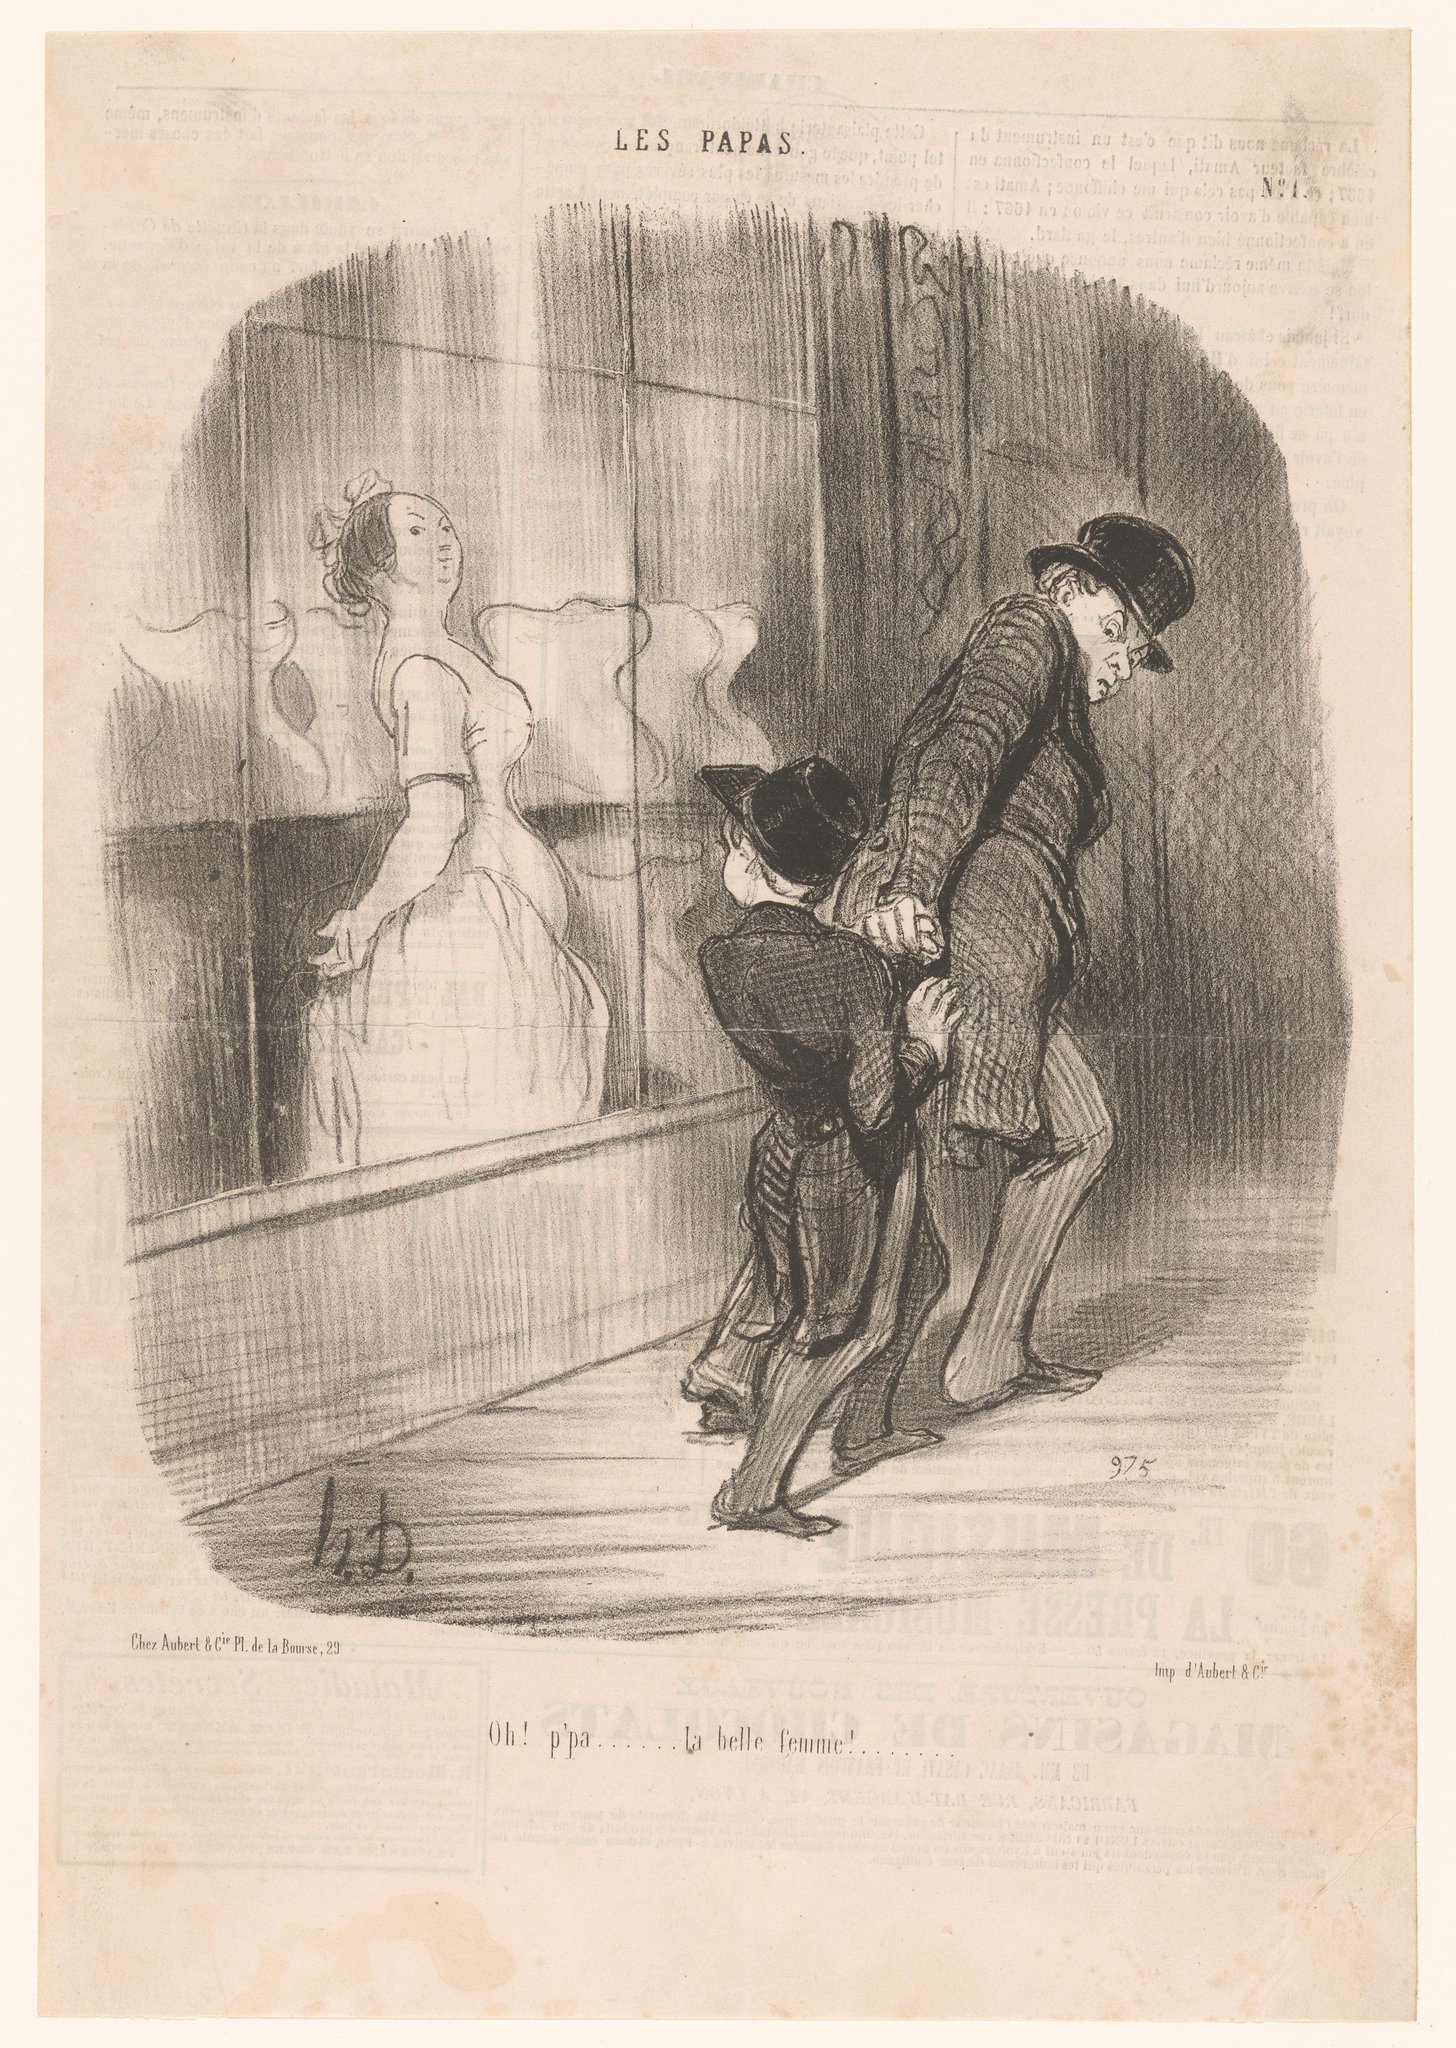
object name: cartoon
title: Vaders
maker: honoré daumier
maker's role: draughtsman, painter, print maker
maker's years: 1808-1879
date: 1846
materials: paper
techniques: lithograph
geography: paris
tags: caricatures (human types), model, mannequin, father and son(s) (family group) (with number of sons), shop-window, show-window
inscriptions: stamp: ‘Timbre Royal Seine’, collector's mark: Lugt 2228a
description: Prent gebruikt voor: Le Charivari, 10-12-1846.